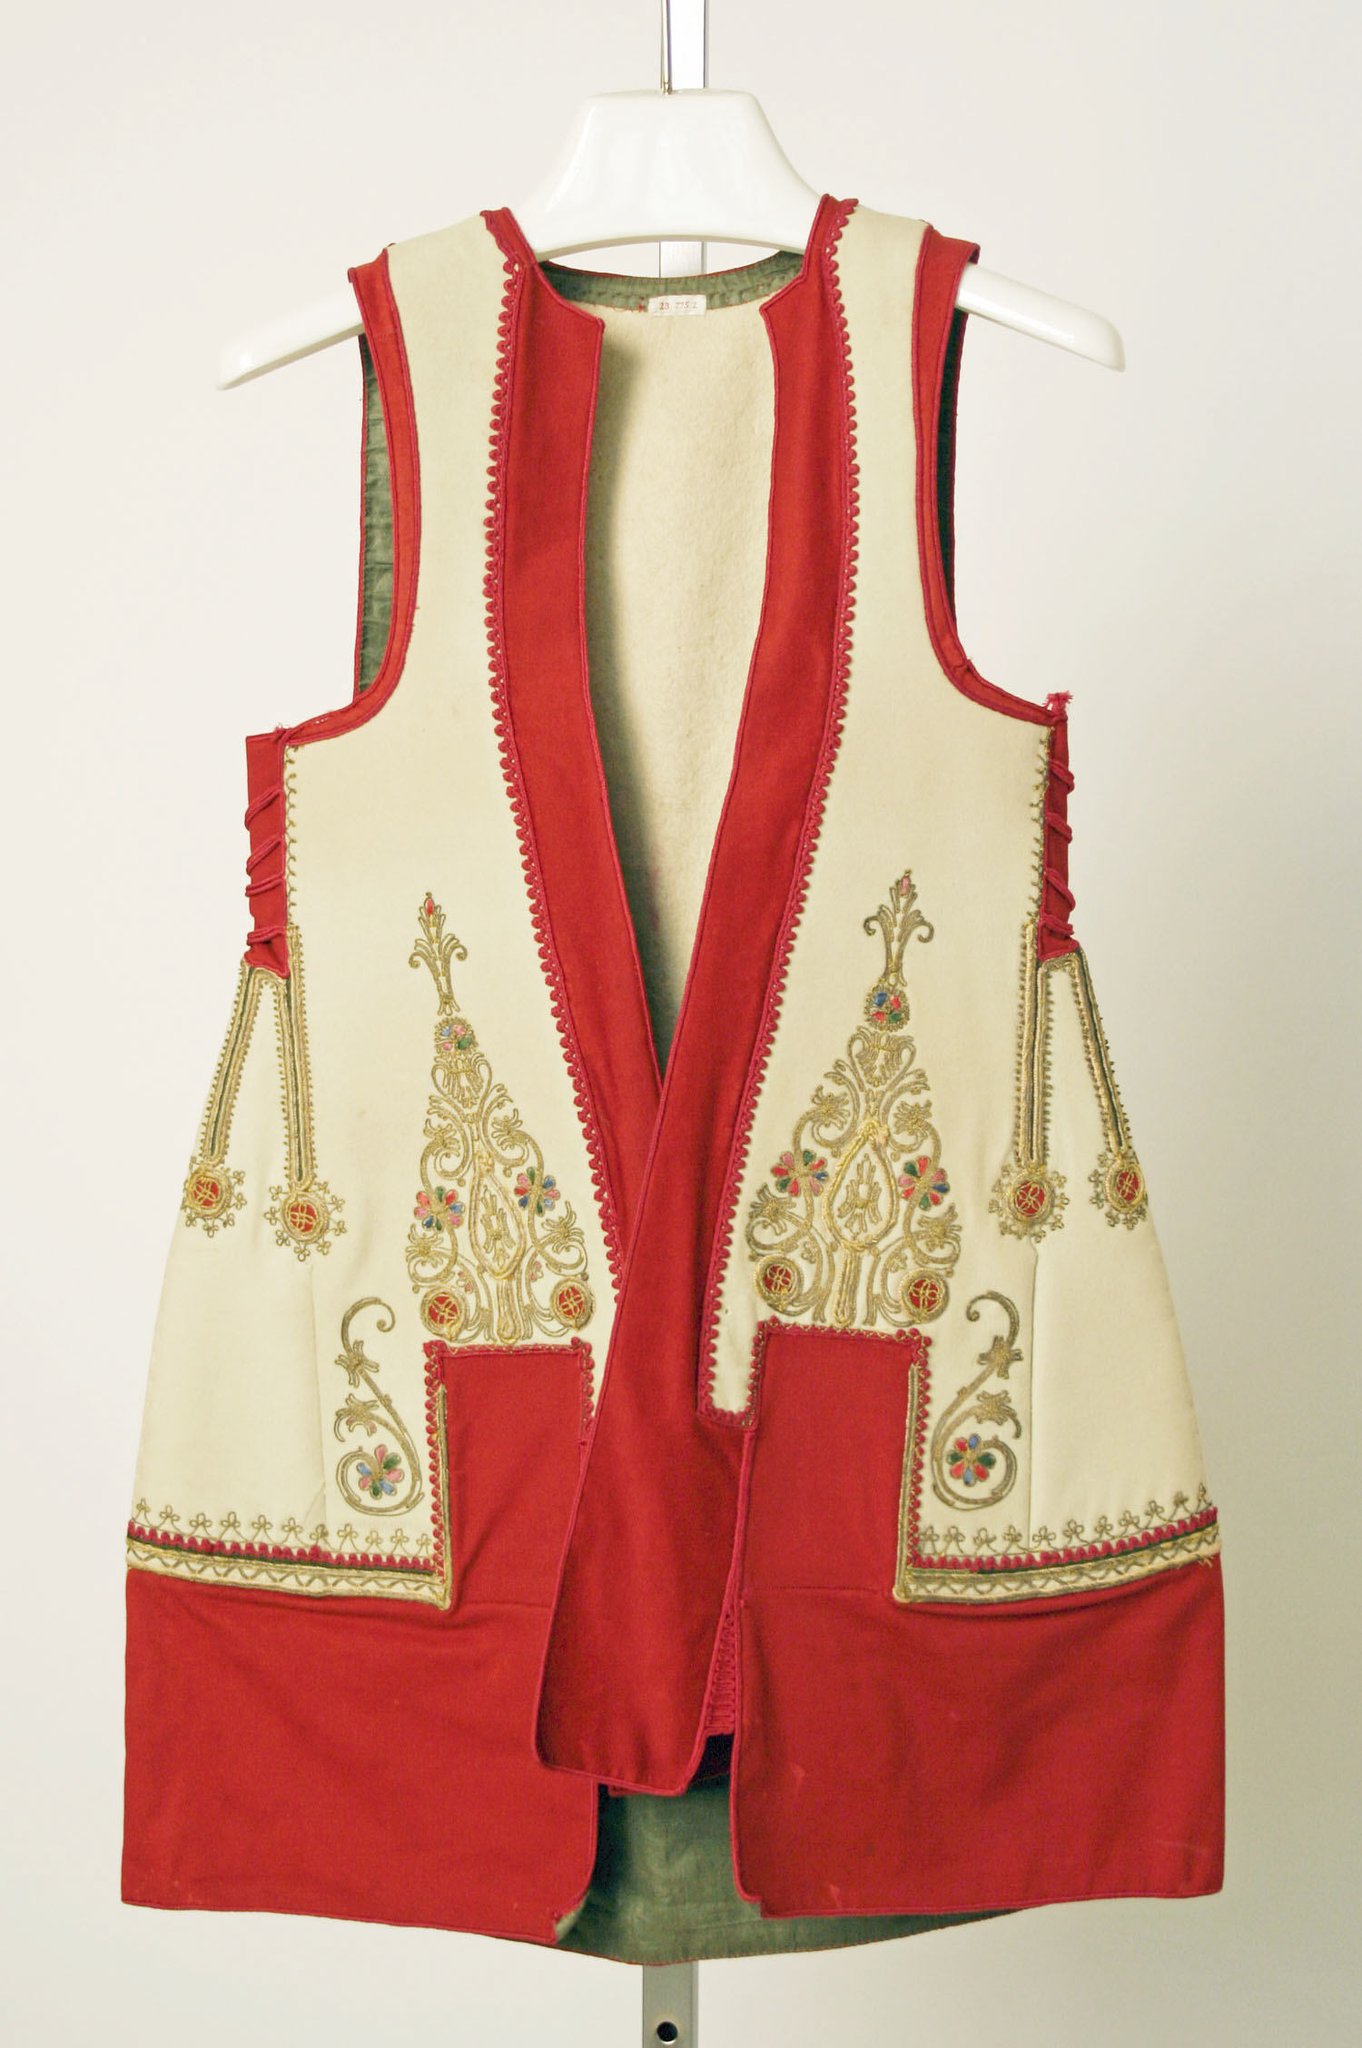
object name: jacket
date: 1801-1900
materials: cotton, silk